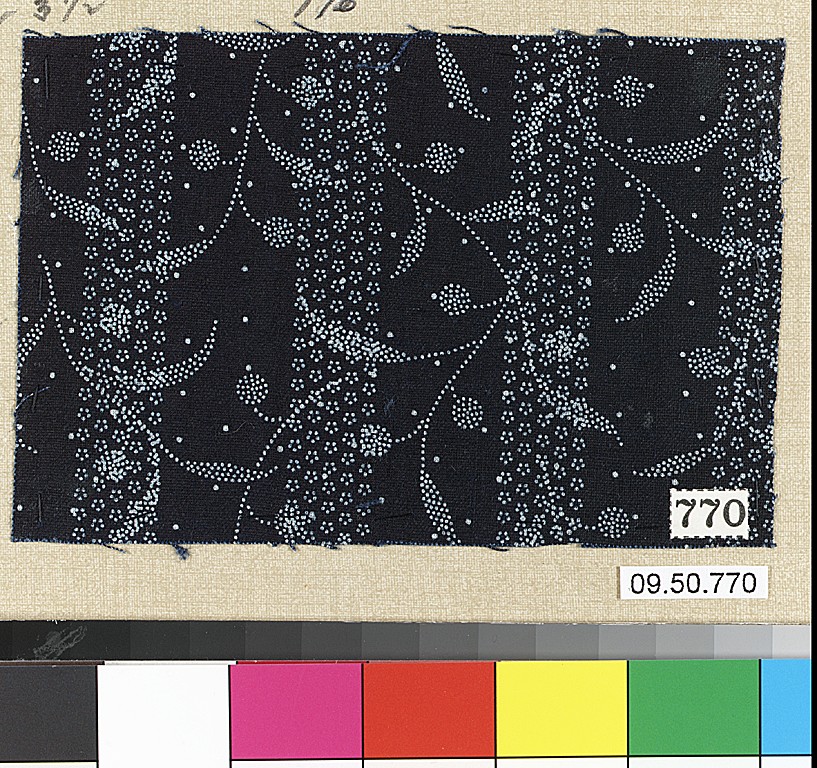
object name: piece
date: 1801-1900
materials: cotton